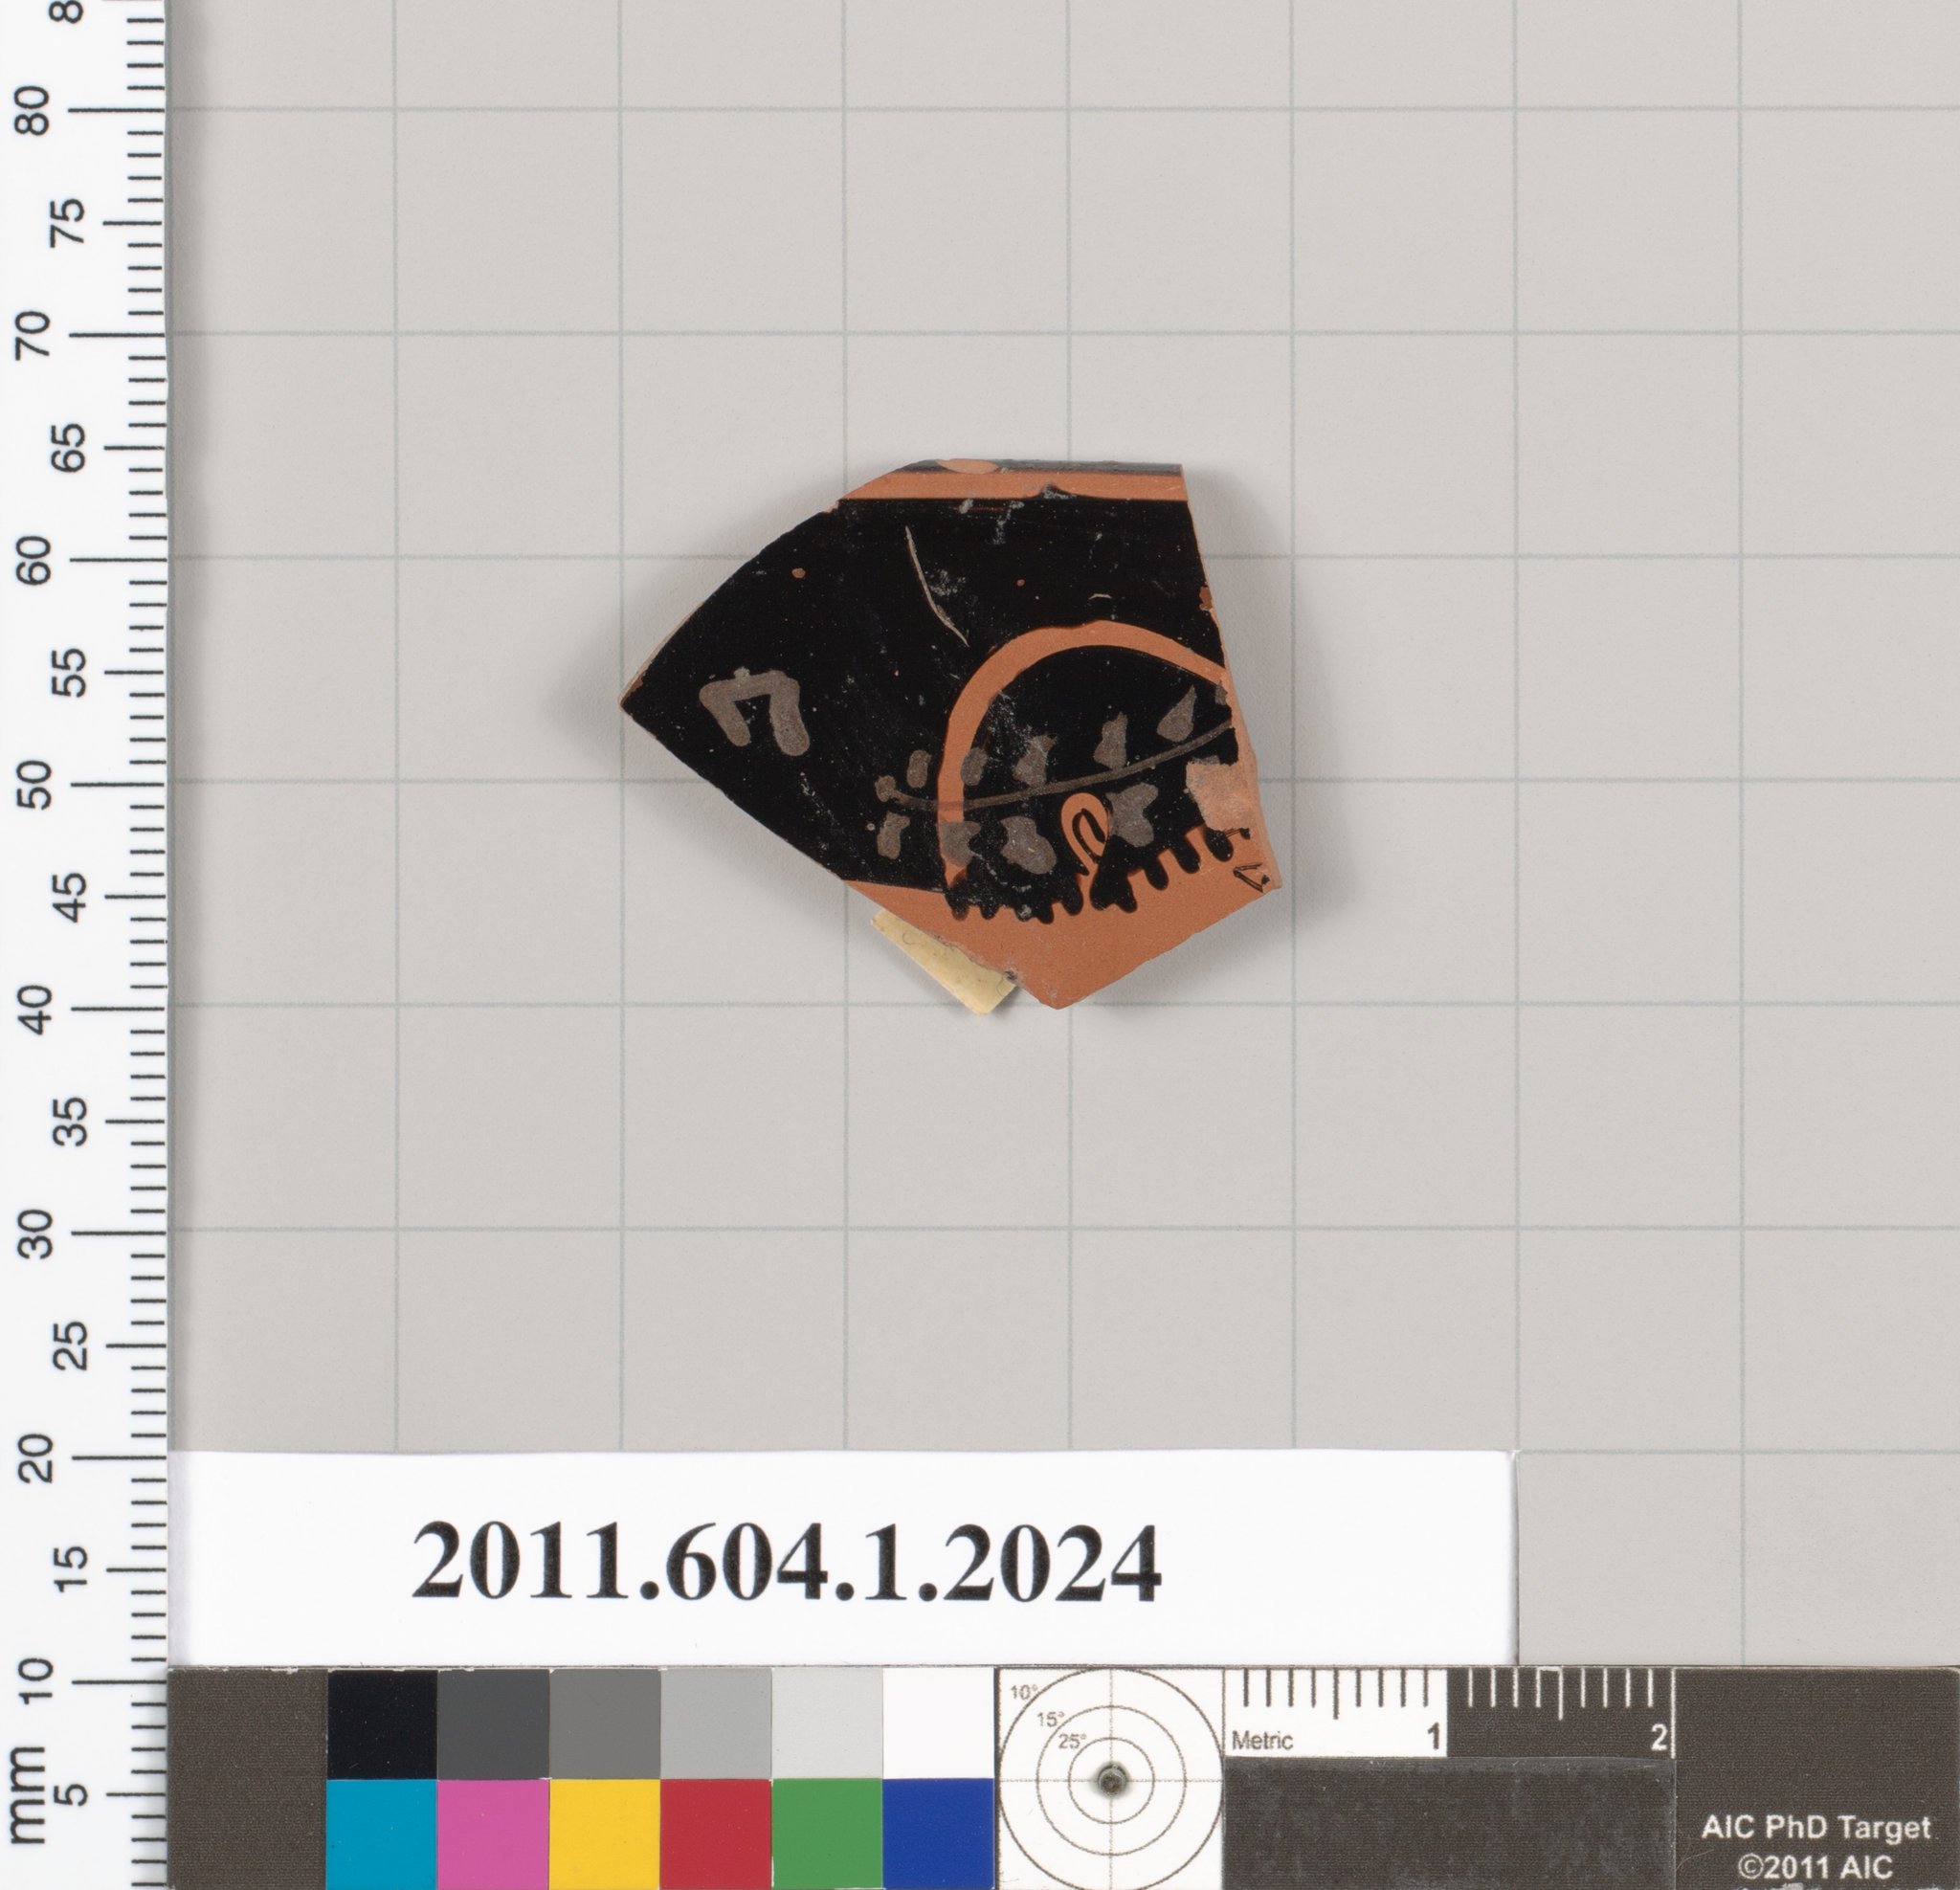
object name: kylix fragment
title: Terracotta rim fragment of a kylix (drinking cup)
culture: greek, attic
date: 534-501 BCE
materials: terracotta